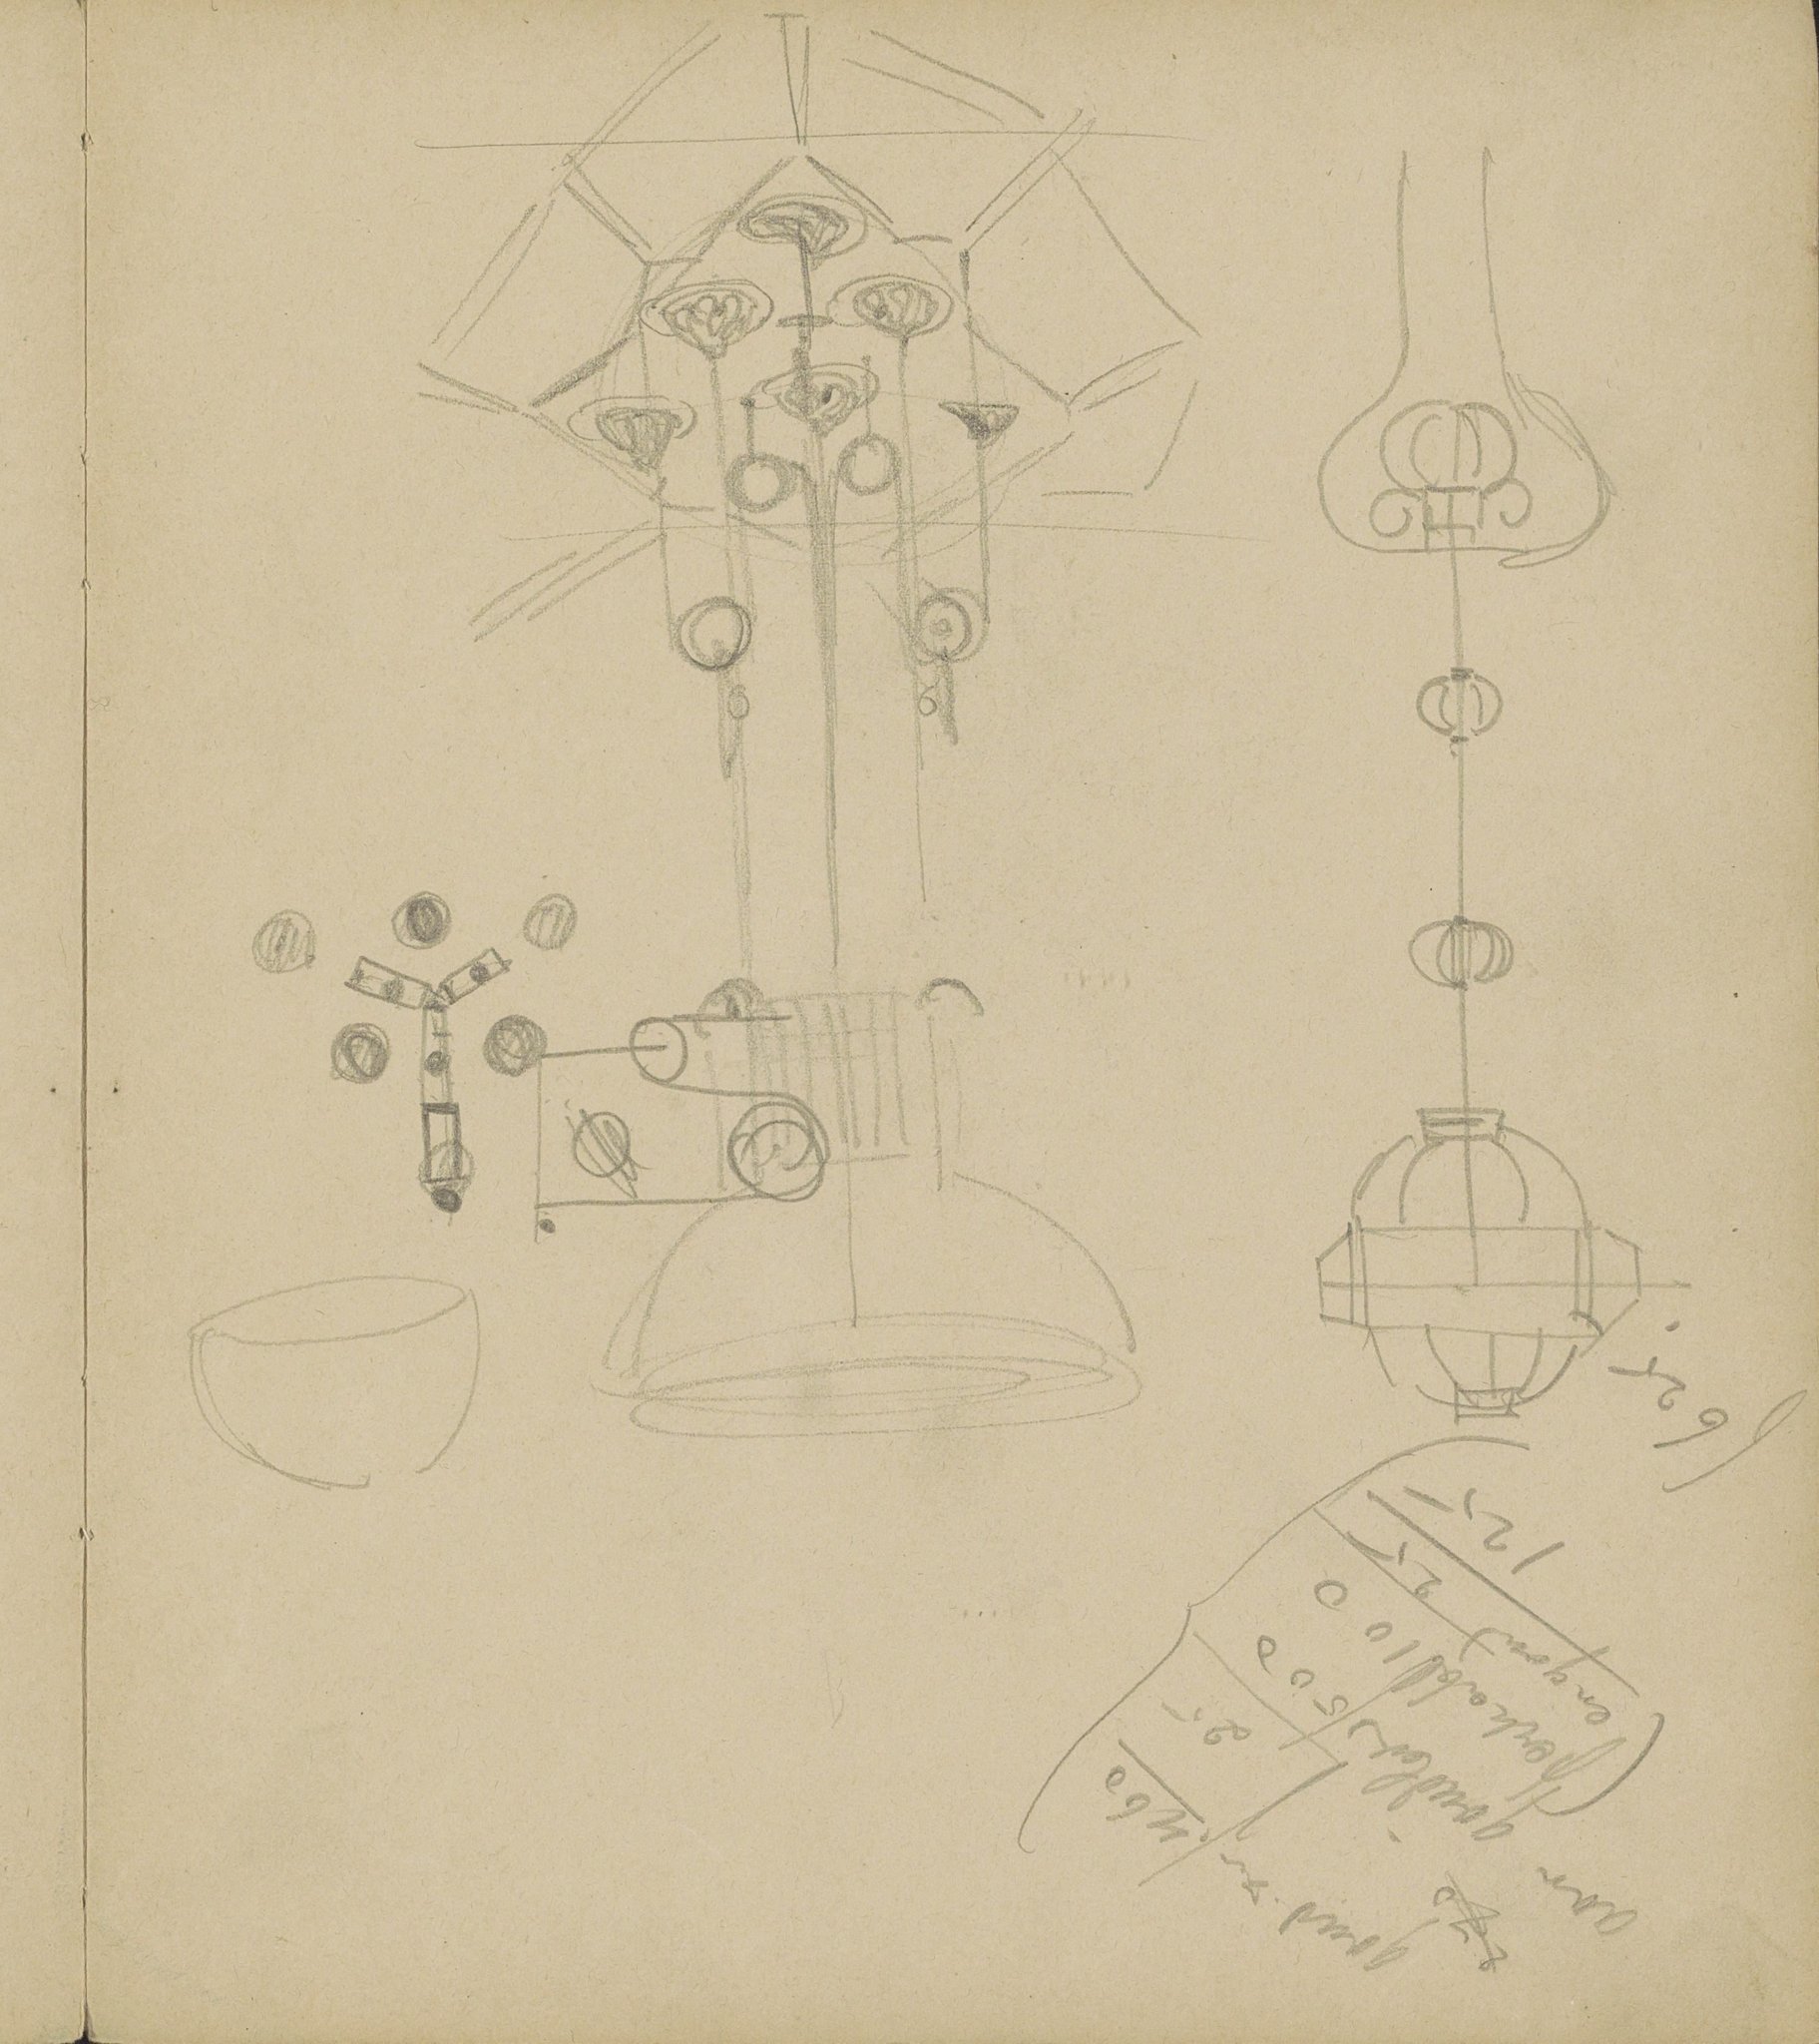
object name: sketchbook leaf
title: Ontwerpen voor hanglampen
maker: carel adolph lion cachet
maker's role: draughtsman, print maker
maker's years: 1864-1945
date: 1905-1906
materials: paper, pencil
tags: lighting; lamps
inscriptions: annotation: ‘goud [...]/ aan goud[...]/ per[...]’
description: Blad 14 recto uit een schetsboek met 30 bladen.